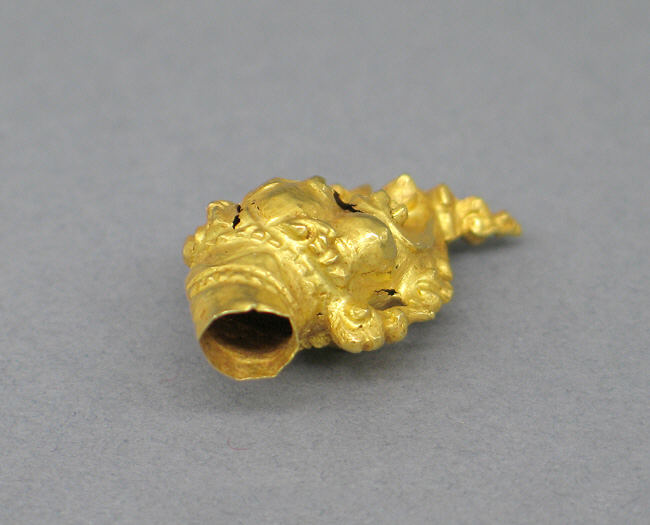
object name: finial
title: Set of Two Rod Finials in Foliate Shape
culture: indonesian, javanese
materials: gold